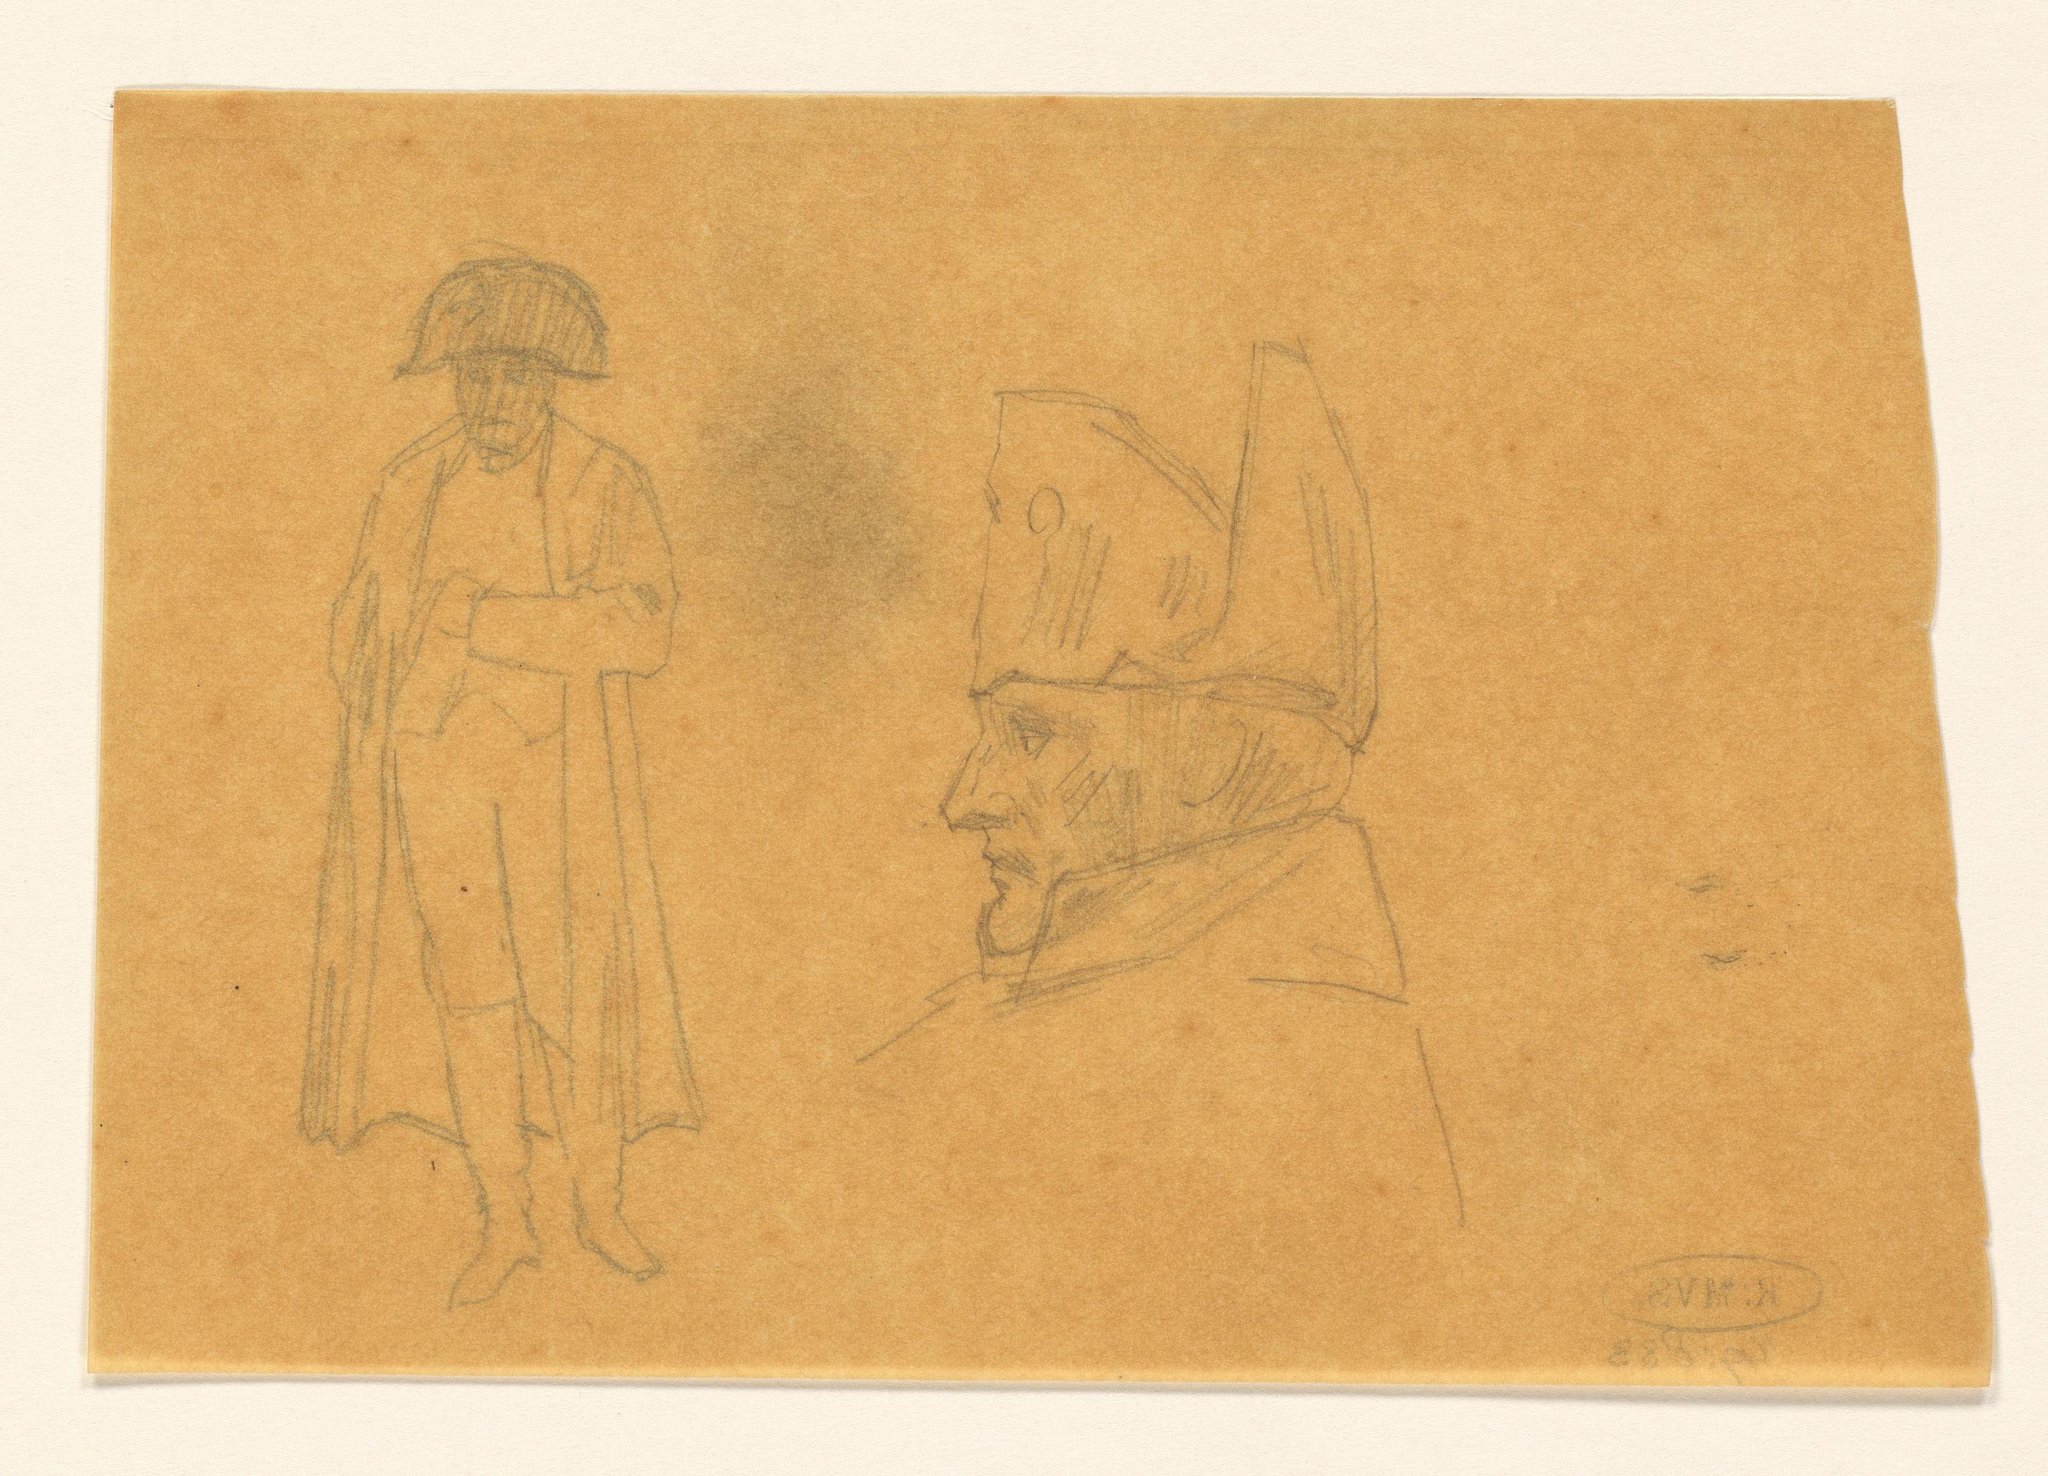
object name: drawing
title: Schetsblad met twee studies van Napoleon, een ten voeten uit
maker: august allebé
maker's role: draughtsman, print maker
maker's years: 1838-1927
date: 1848-1927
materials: pencil, paper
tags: napoleon i (emperor of the french), historical persons